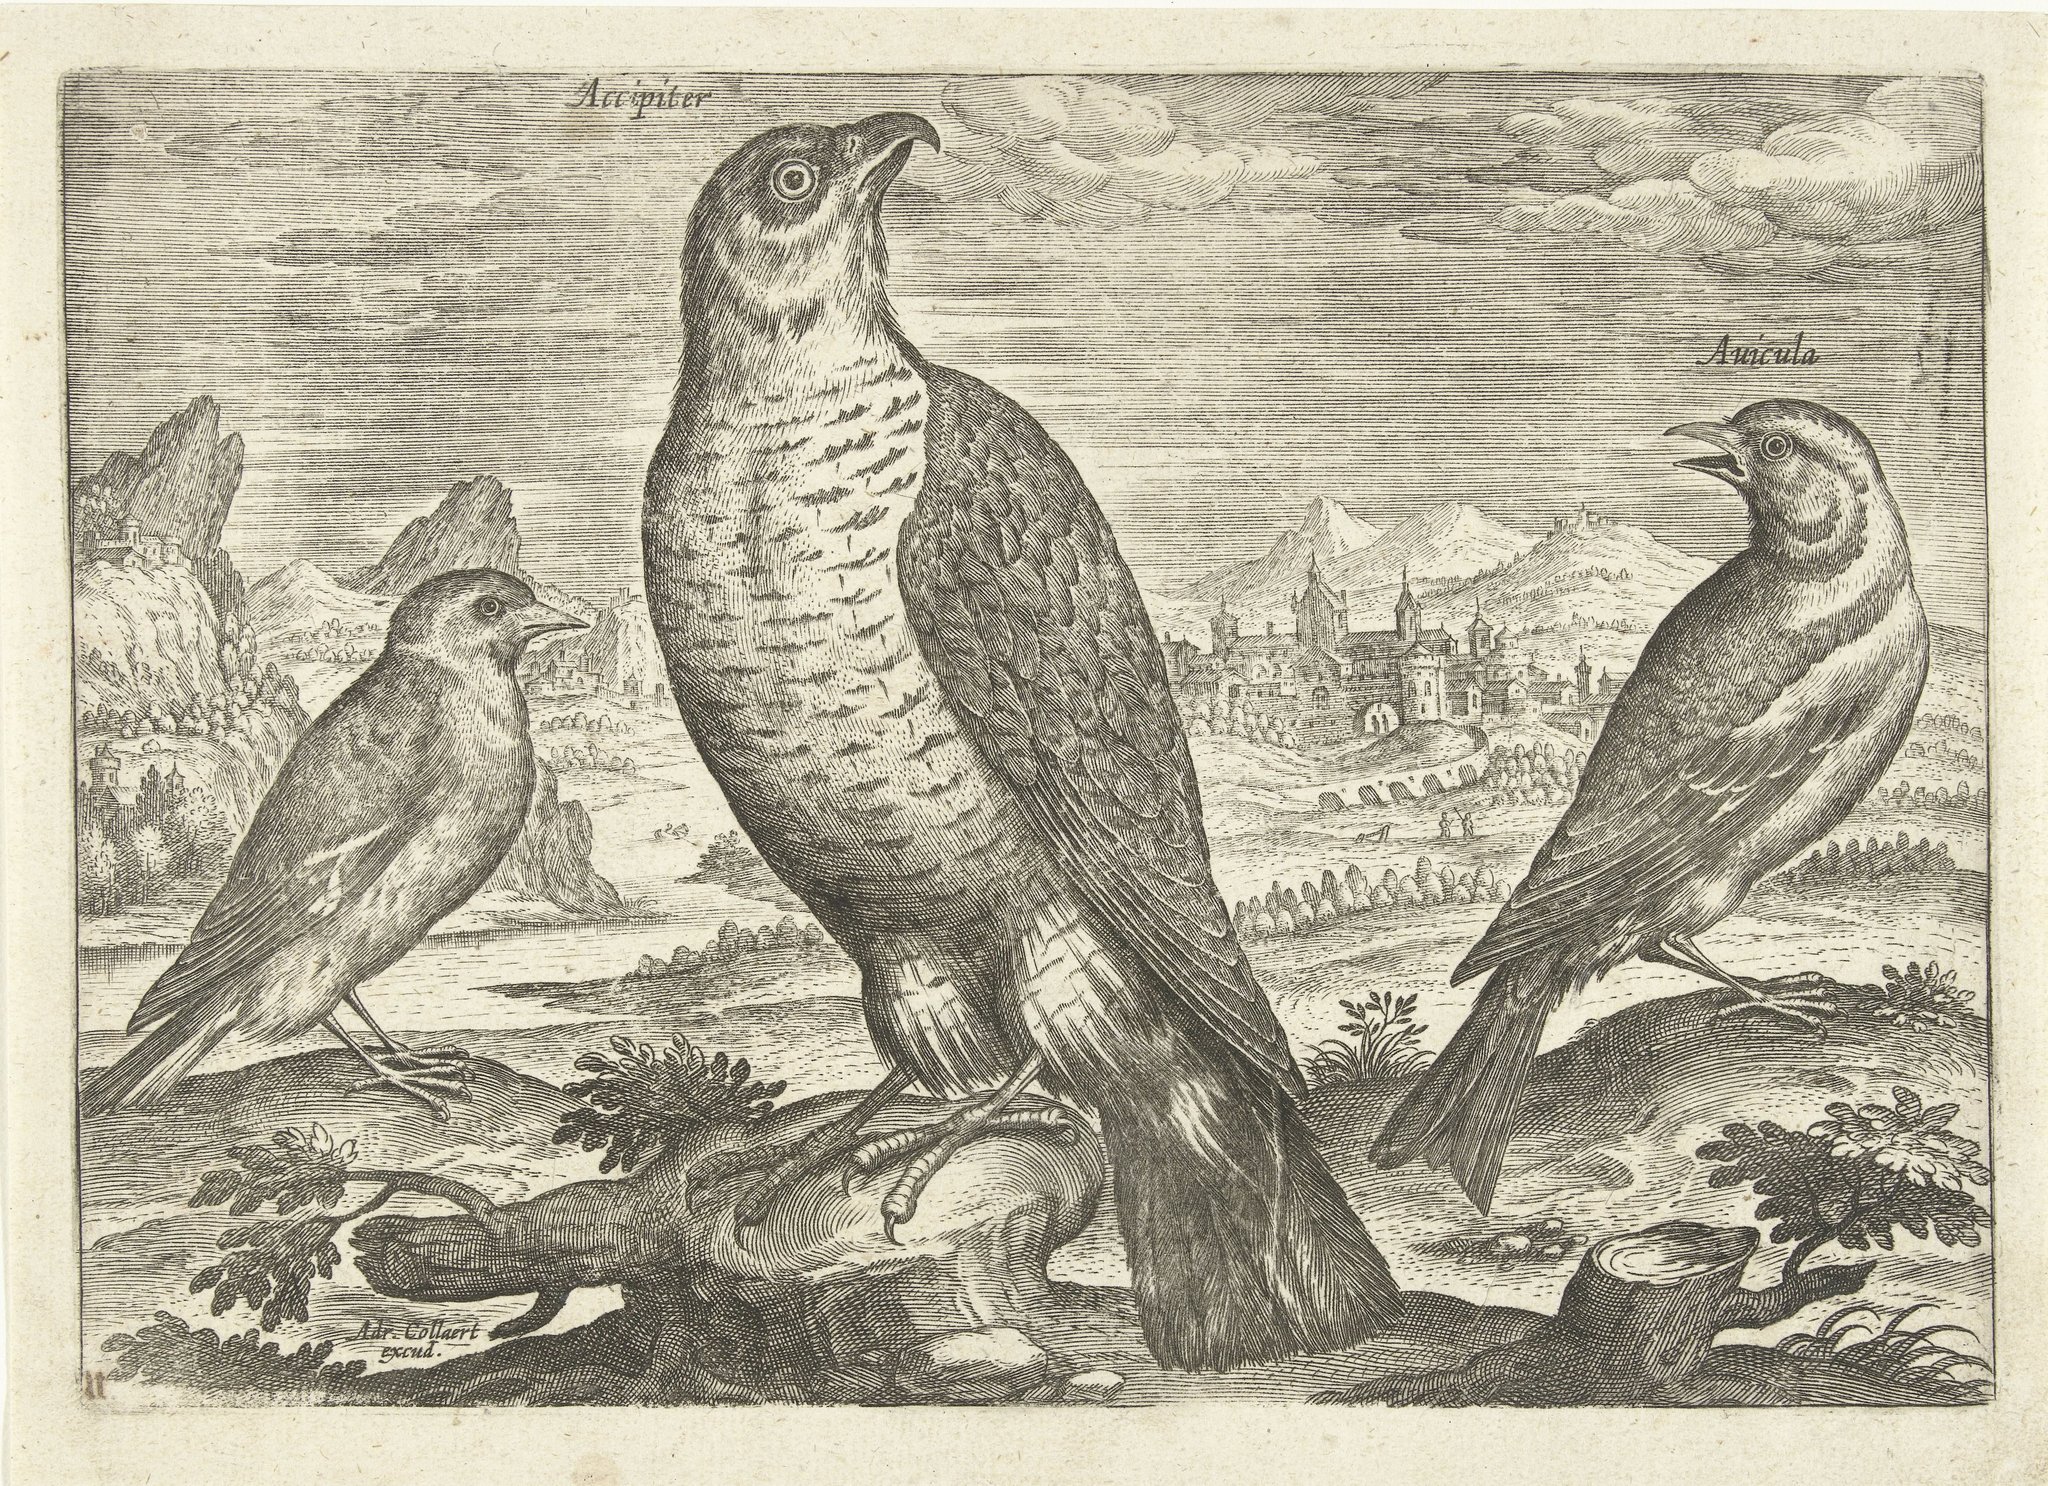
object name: print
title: Vogels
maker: adriaen collaert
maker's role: draughtsman, print maker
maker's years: 1560-1618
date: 1598-1602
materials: paper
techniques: engraving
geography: antwerp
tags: predatory birds: hawk, song-birds: sparrow, city-view in general; 'veduta' (+ city(-scape) with figures, staffage)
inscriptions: collector's mark: Lugt 2228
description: Een havik en twee spreeuwen op de voorgrond. Op de achtergrond een landschap met een stadsgezicht. De prent maakt deel uit van een serie met vogels als onderwerp.